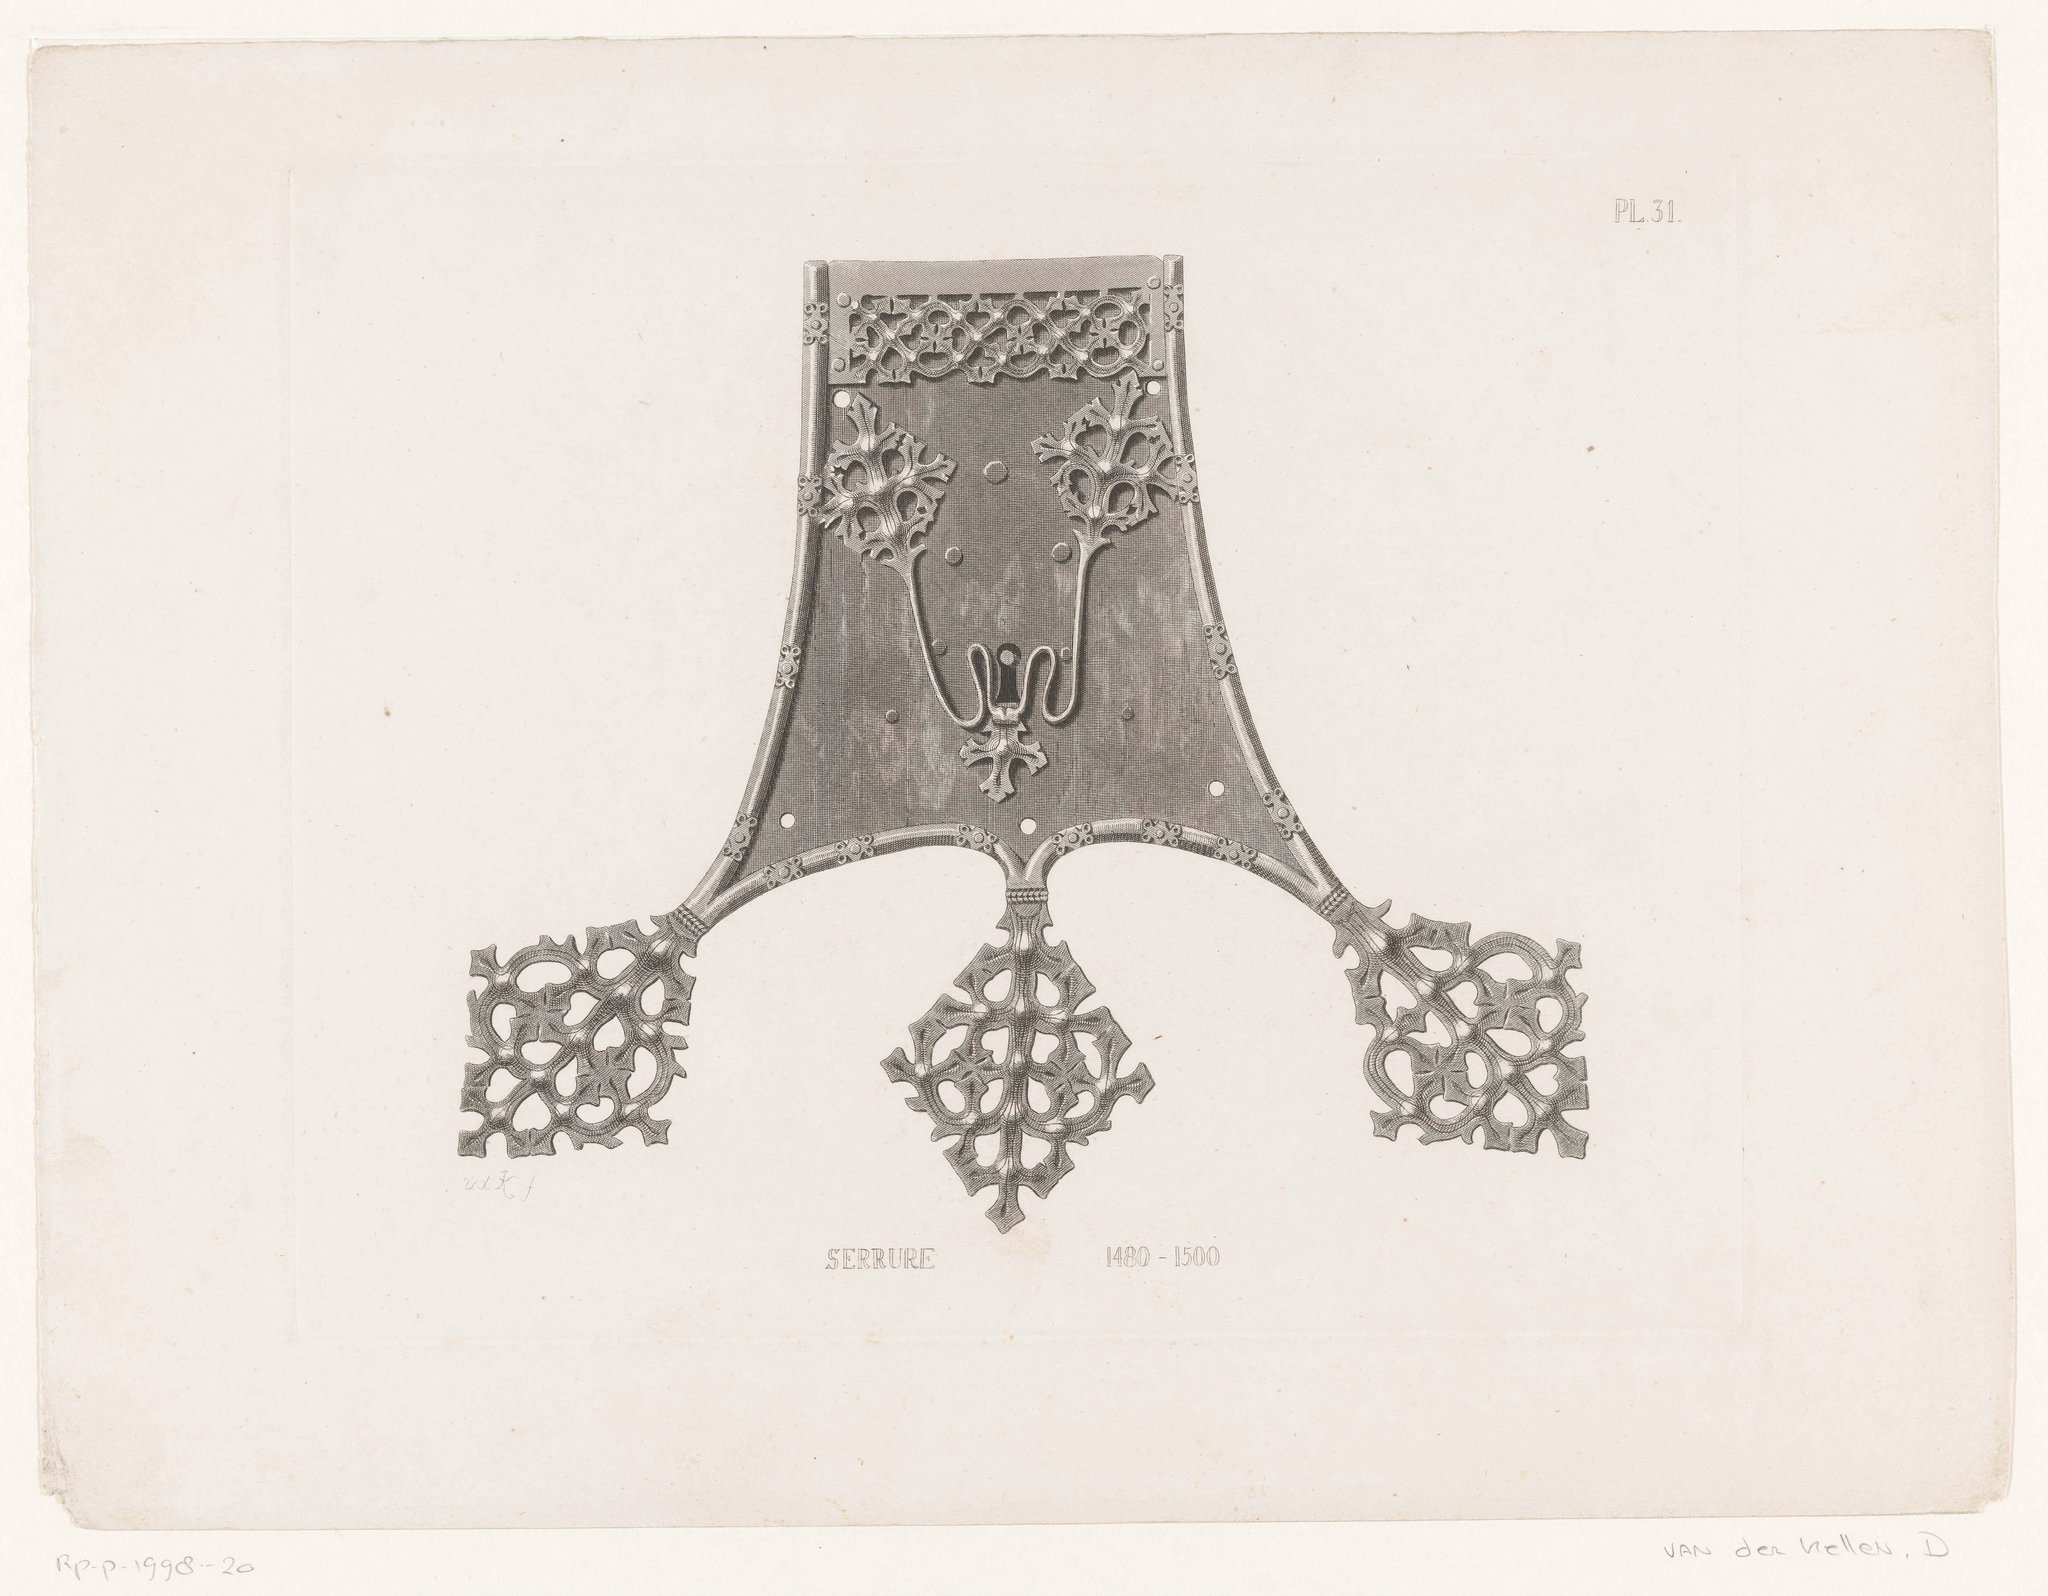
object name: print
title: Serrure 1480-1500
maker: david van der kellen (1804-1879)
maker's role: die cutter, draughtsman, print maker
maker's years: 1804-1879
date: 1865-1878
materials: paper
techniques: etching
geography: netherlands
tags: lock ~ furniture